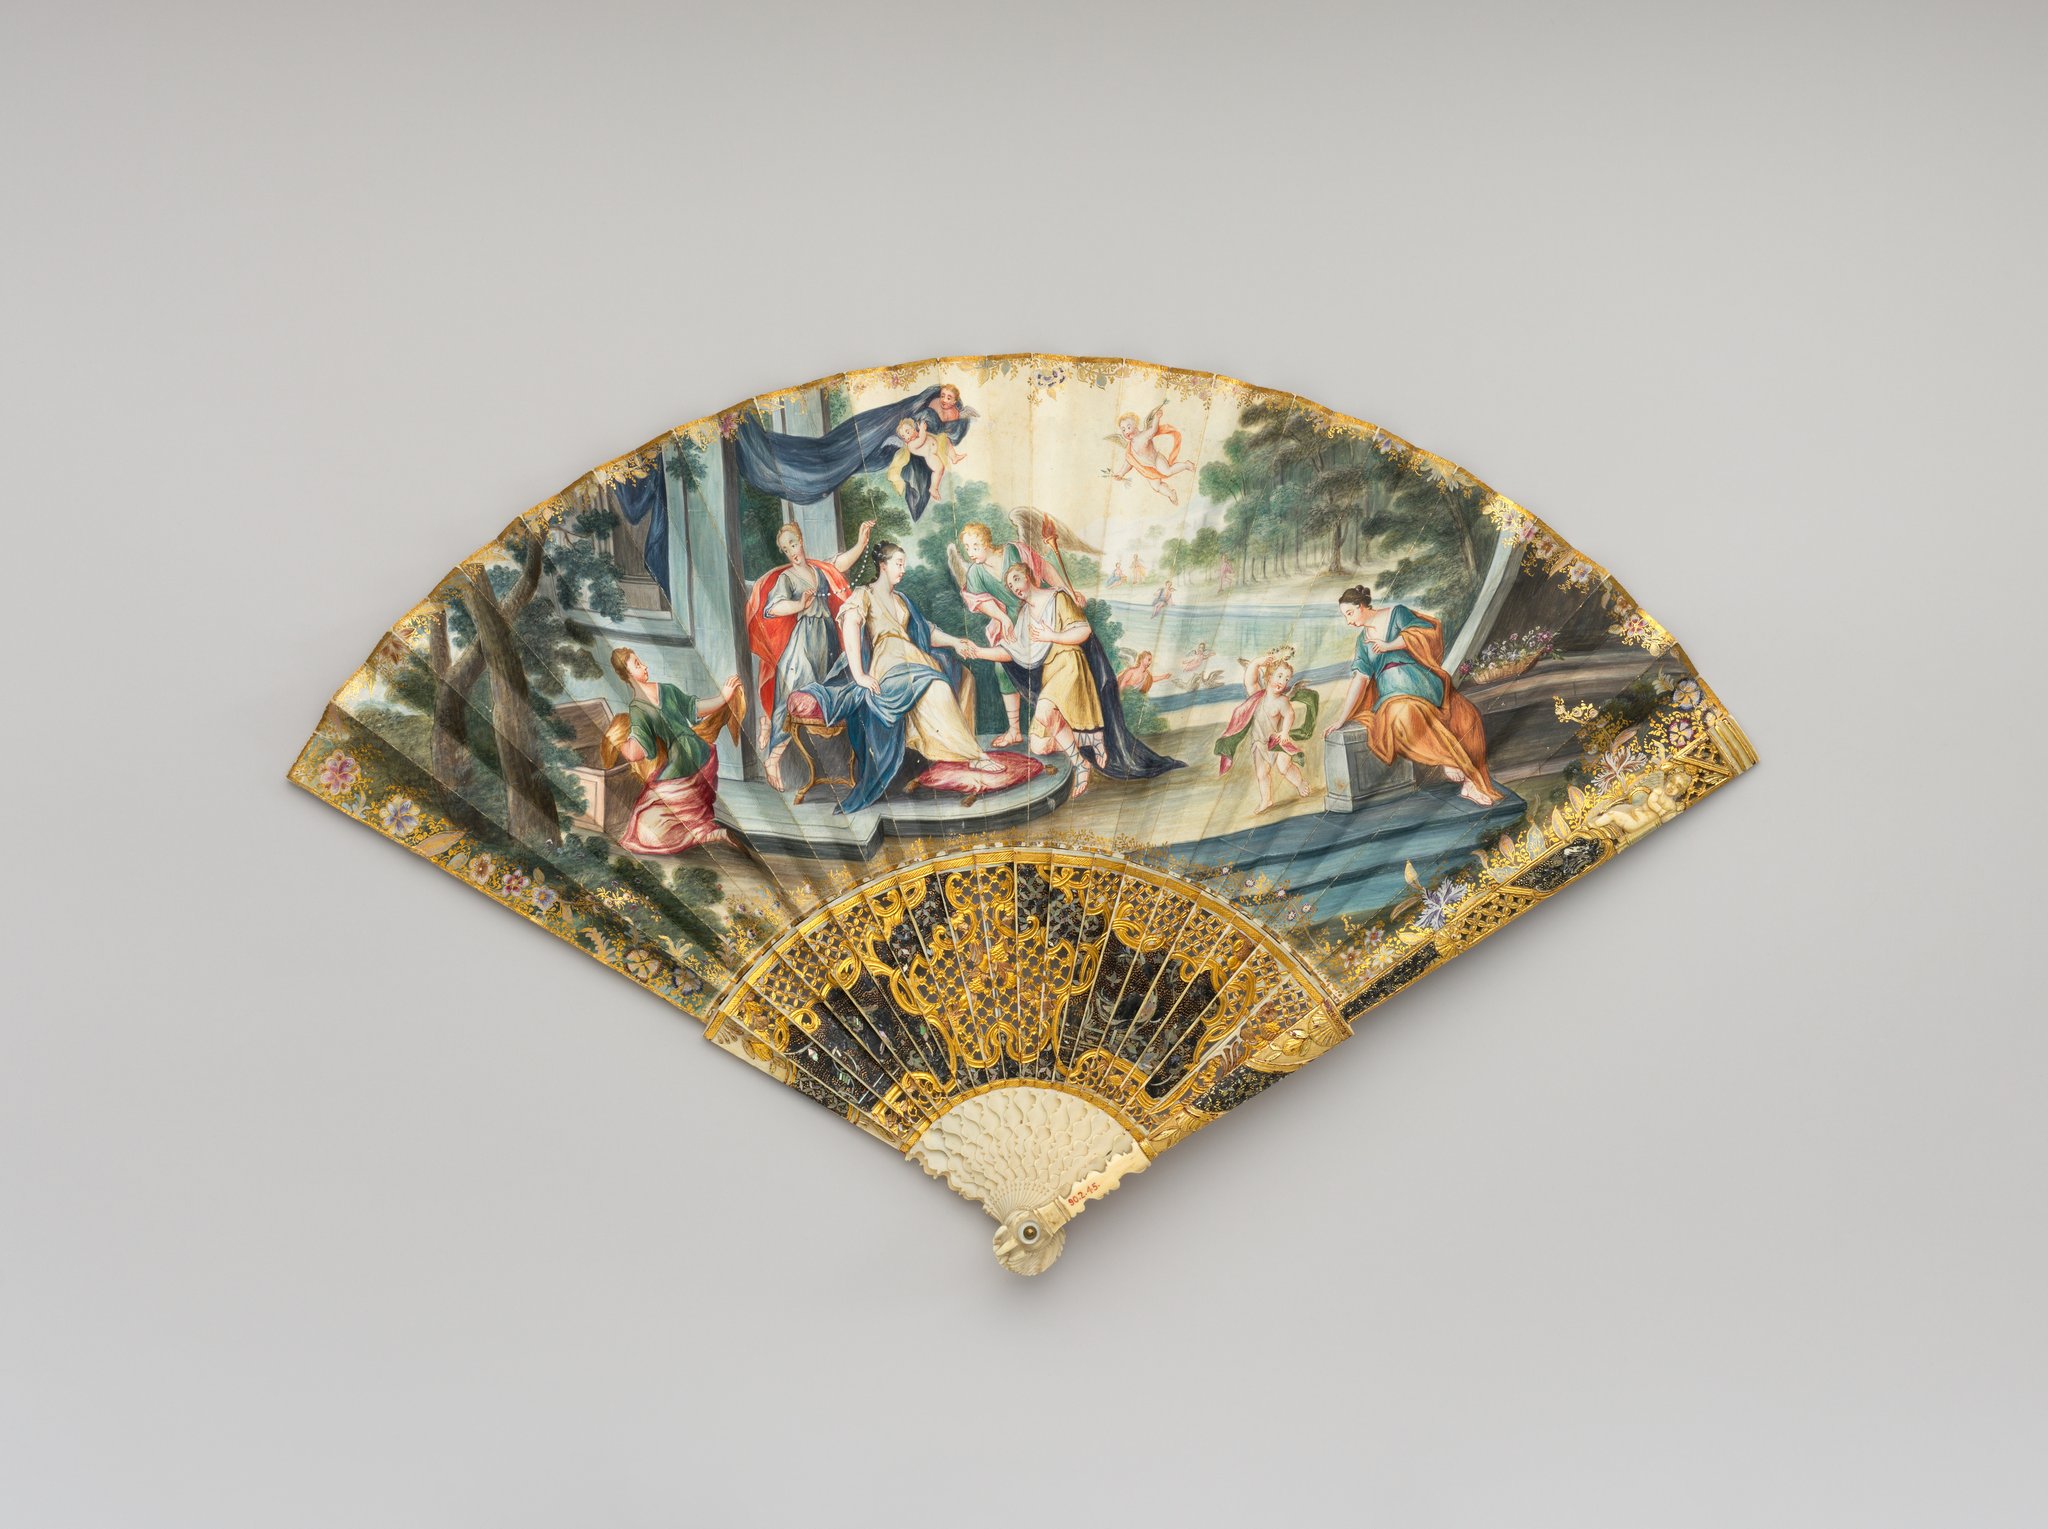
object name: fan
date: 1700-1735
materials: gilt, ivory, lacquer, paint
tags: men,women,cupid